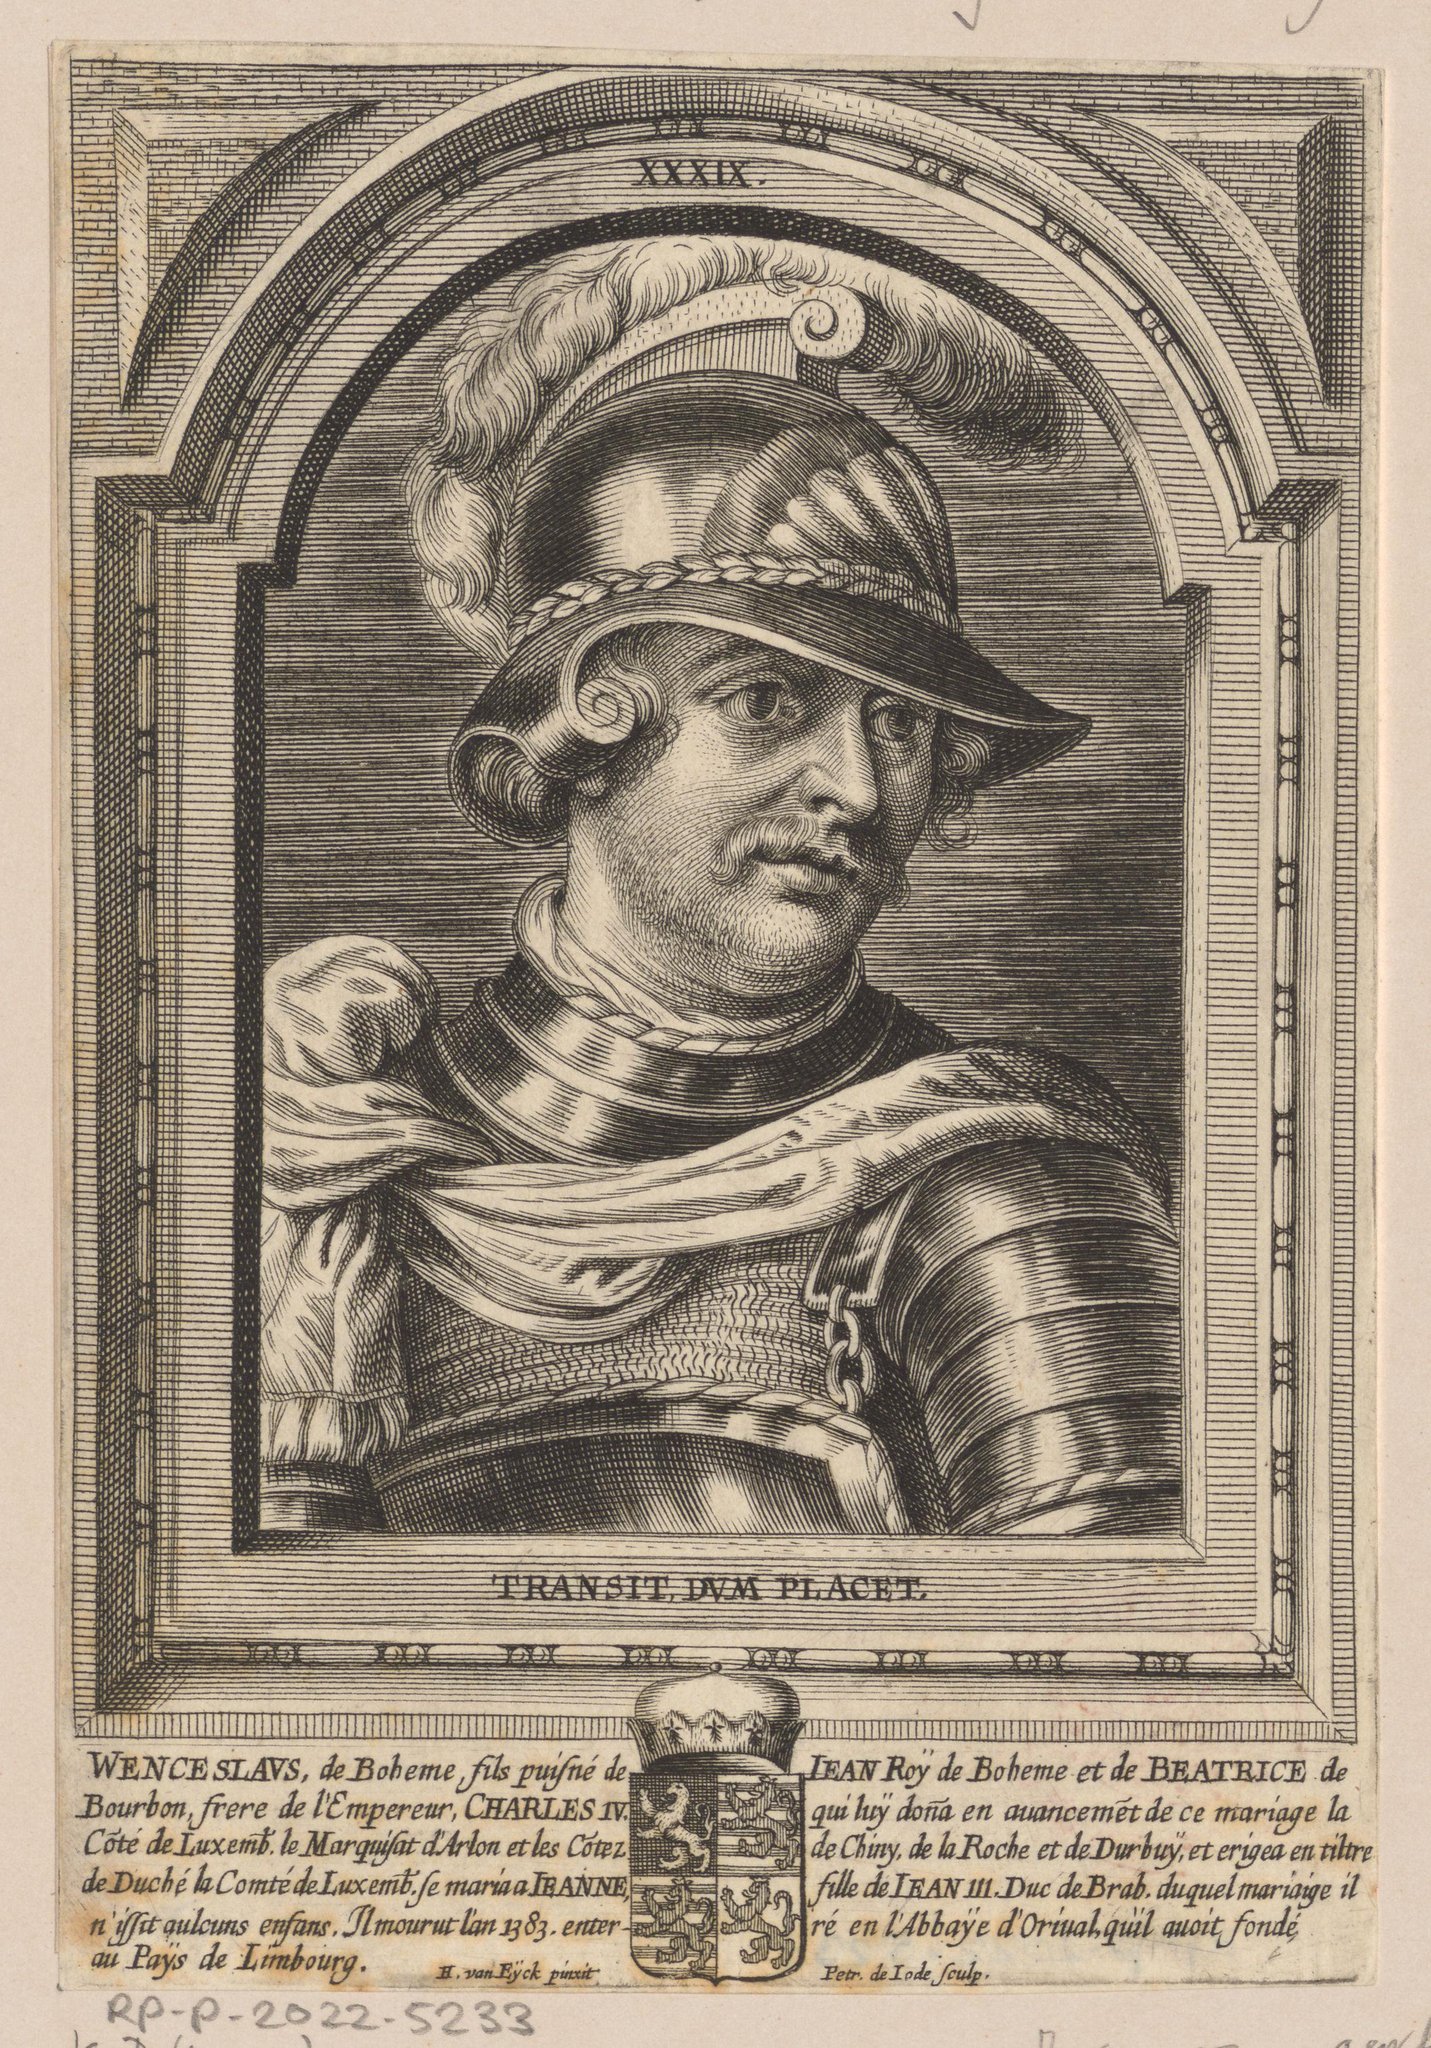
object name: book illustration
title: Portret van Wenceslaus I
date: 1661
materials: paper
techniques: engraving, etching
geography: antwerp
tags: prague, armour, historical persons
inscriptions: collector's mark: Lugt 240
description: Prent uit: Joannes Meyssens, Les effigies des souverains princes et ducs de Brabant avec leur chronologie, armes et devises. Antwerpen: Joannes Meyssens, na 1661.